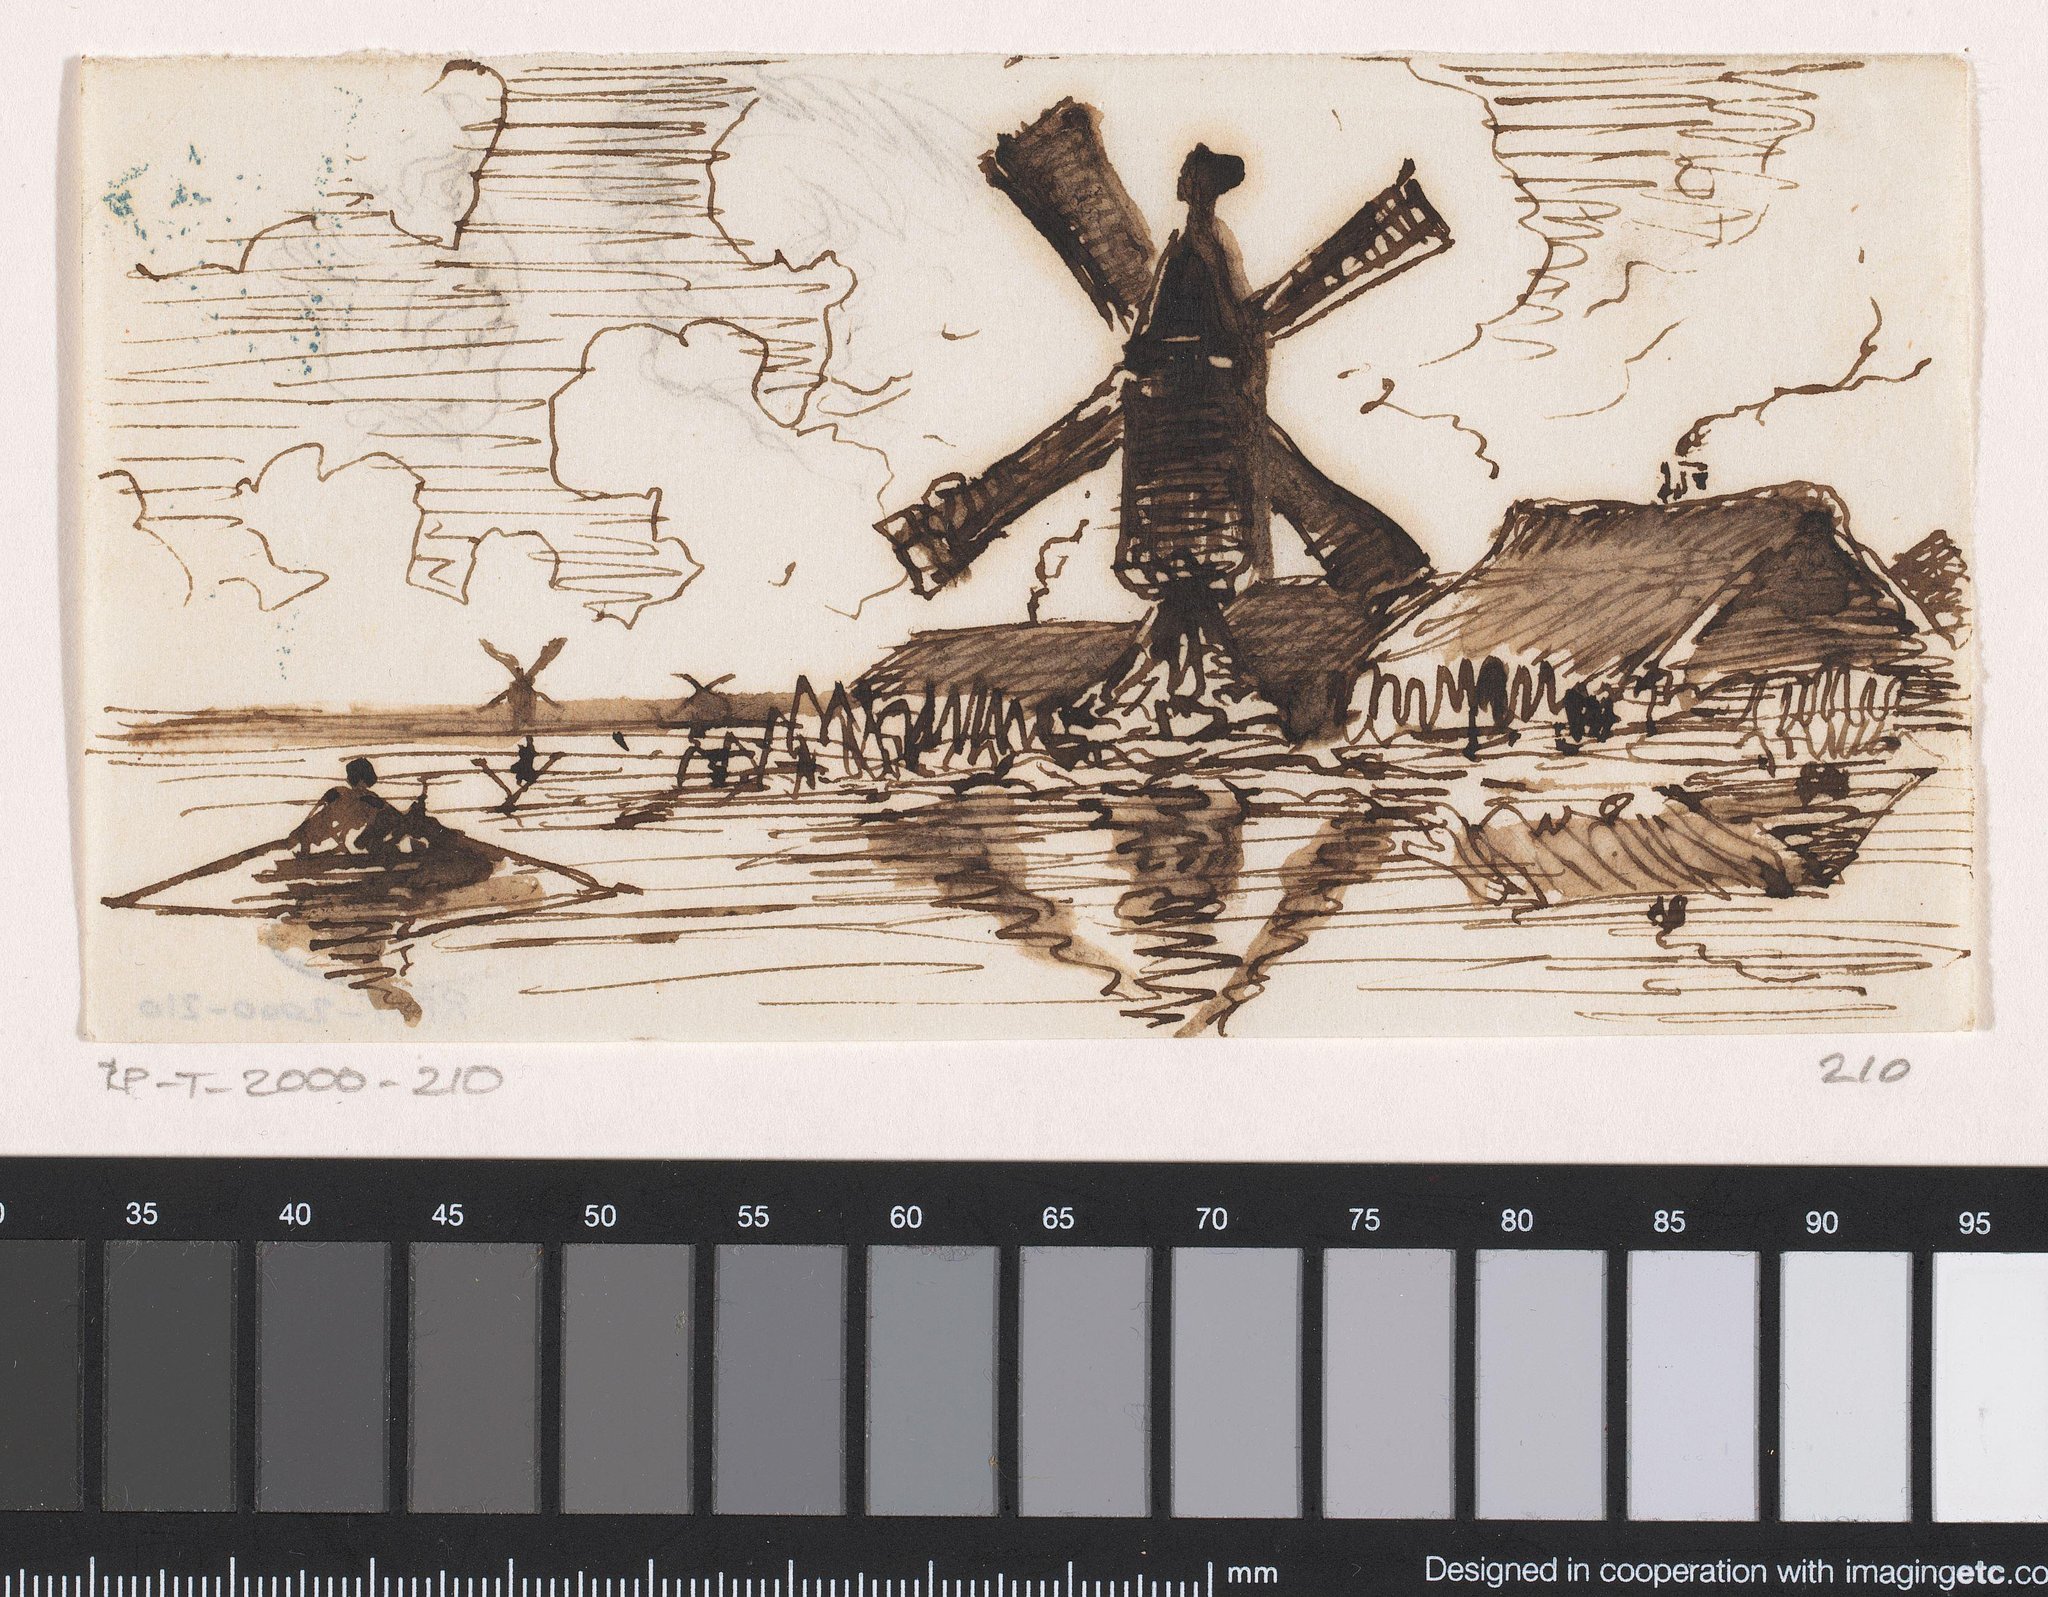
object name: drawing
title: Rivierlandschap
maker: johannes tavenraat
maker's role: draughtsman, painter, print maker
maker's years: 1809-1881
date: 1840-1880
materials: ink, paper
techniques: pen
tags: windmill in landscape, river (+ landscape with figures, staffage)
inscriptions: collector's mark: Lugt 2228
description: Rivierlandschap met roeiboot, molen en boerderij.